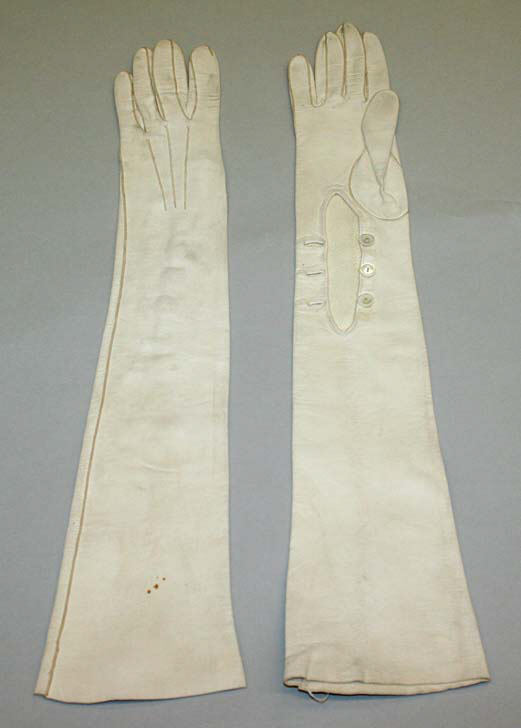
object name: glove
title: Gloves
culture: french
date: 1900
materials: leather